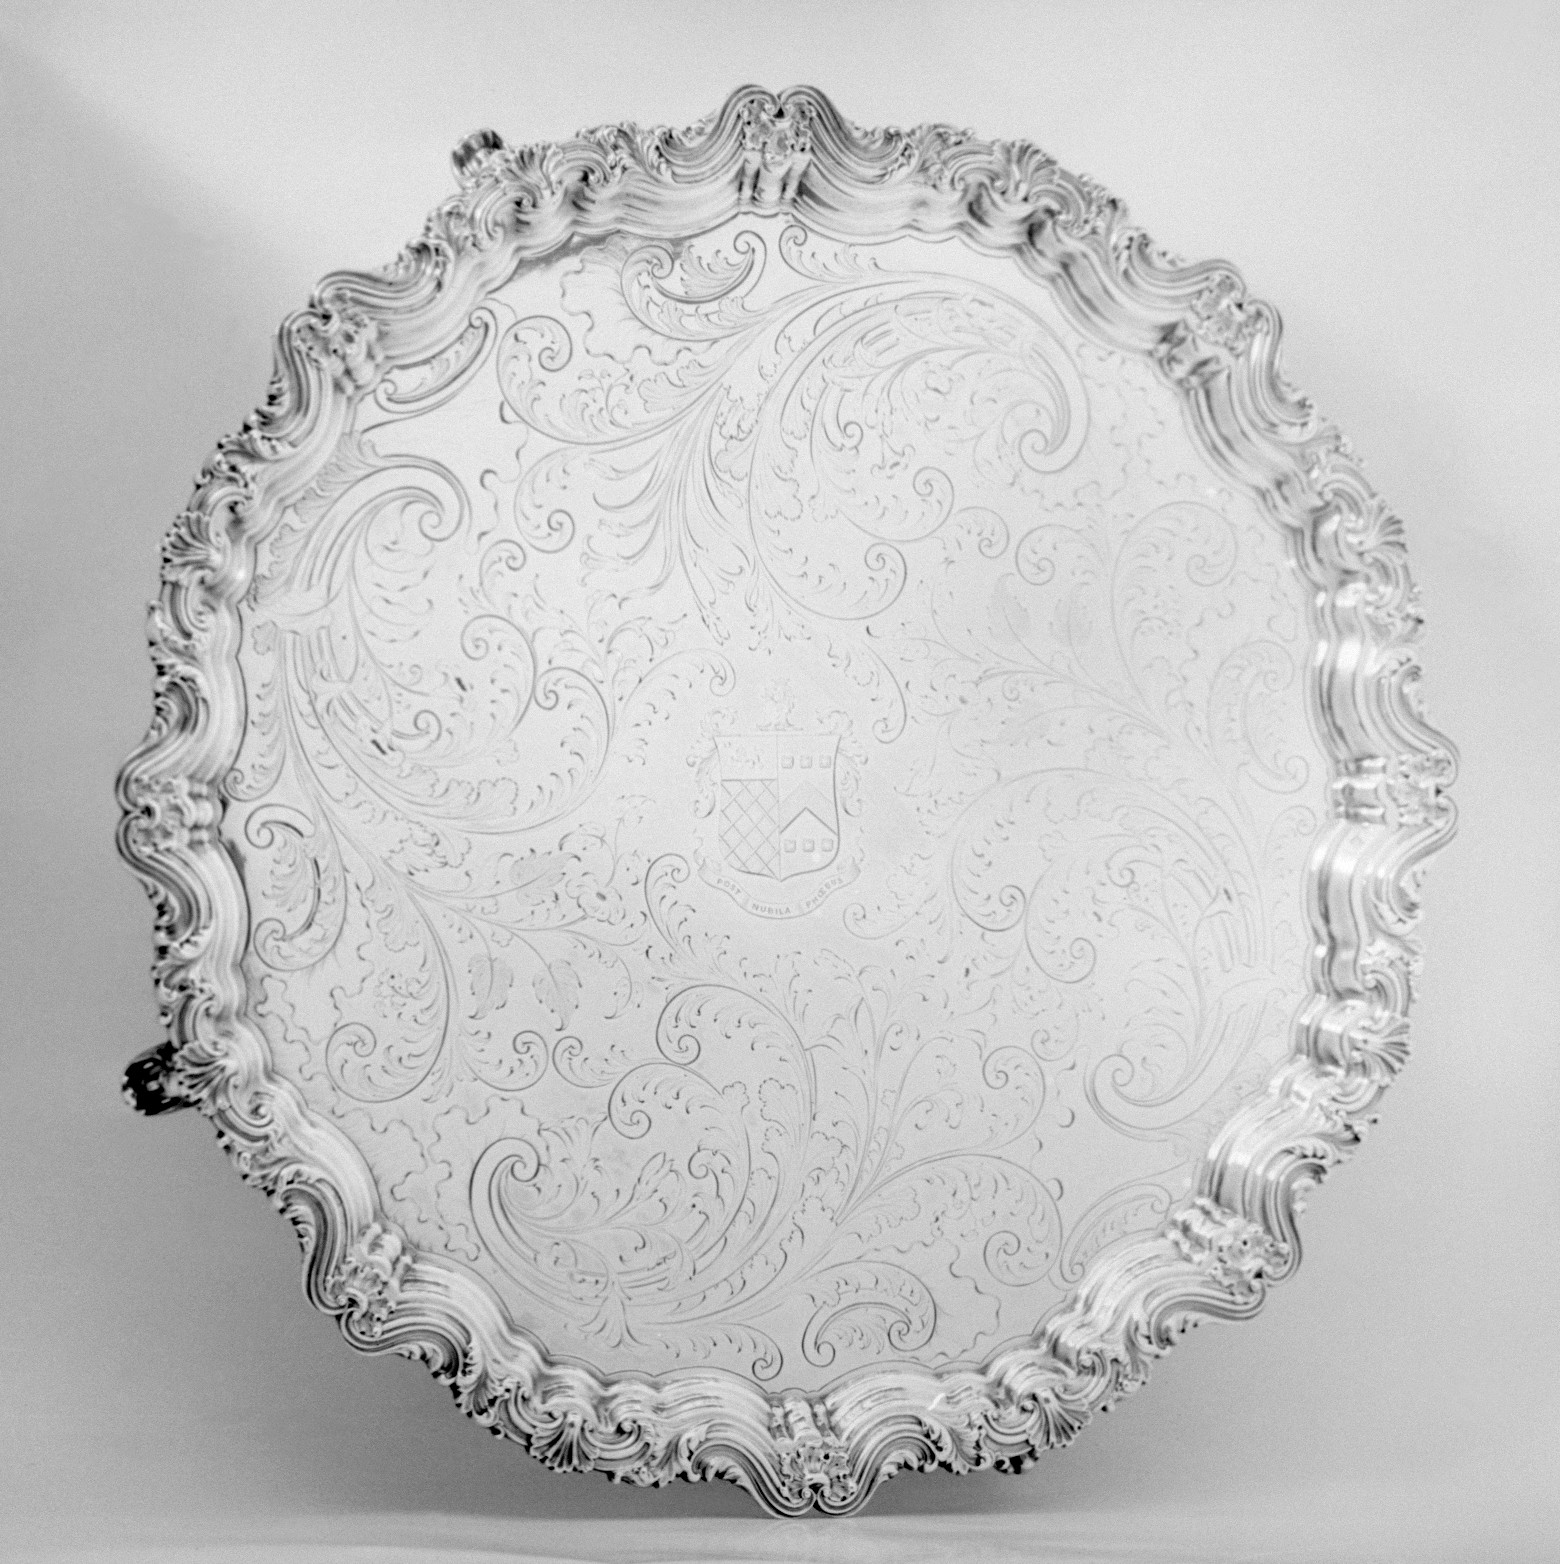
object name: salver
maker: henry wilkinson & co.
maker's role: maker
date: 1834-1835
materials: silver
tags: coat of arms